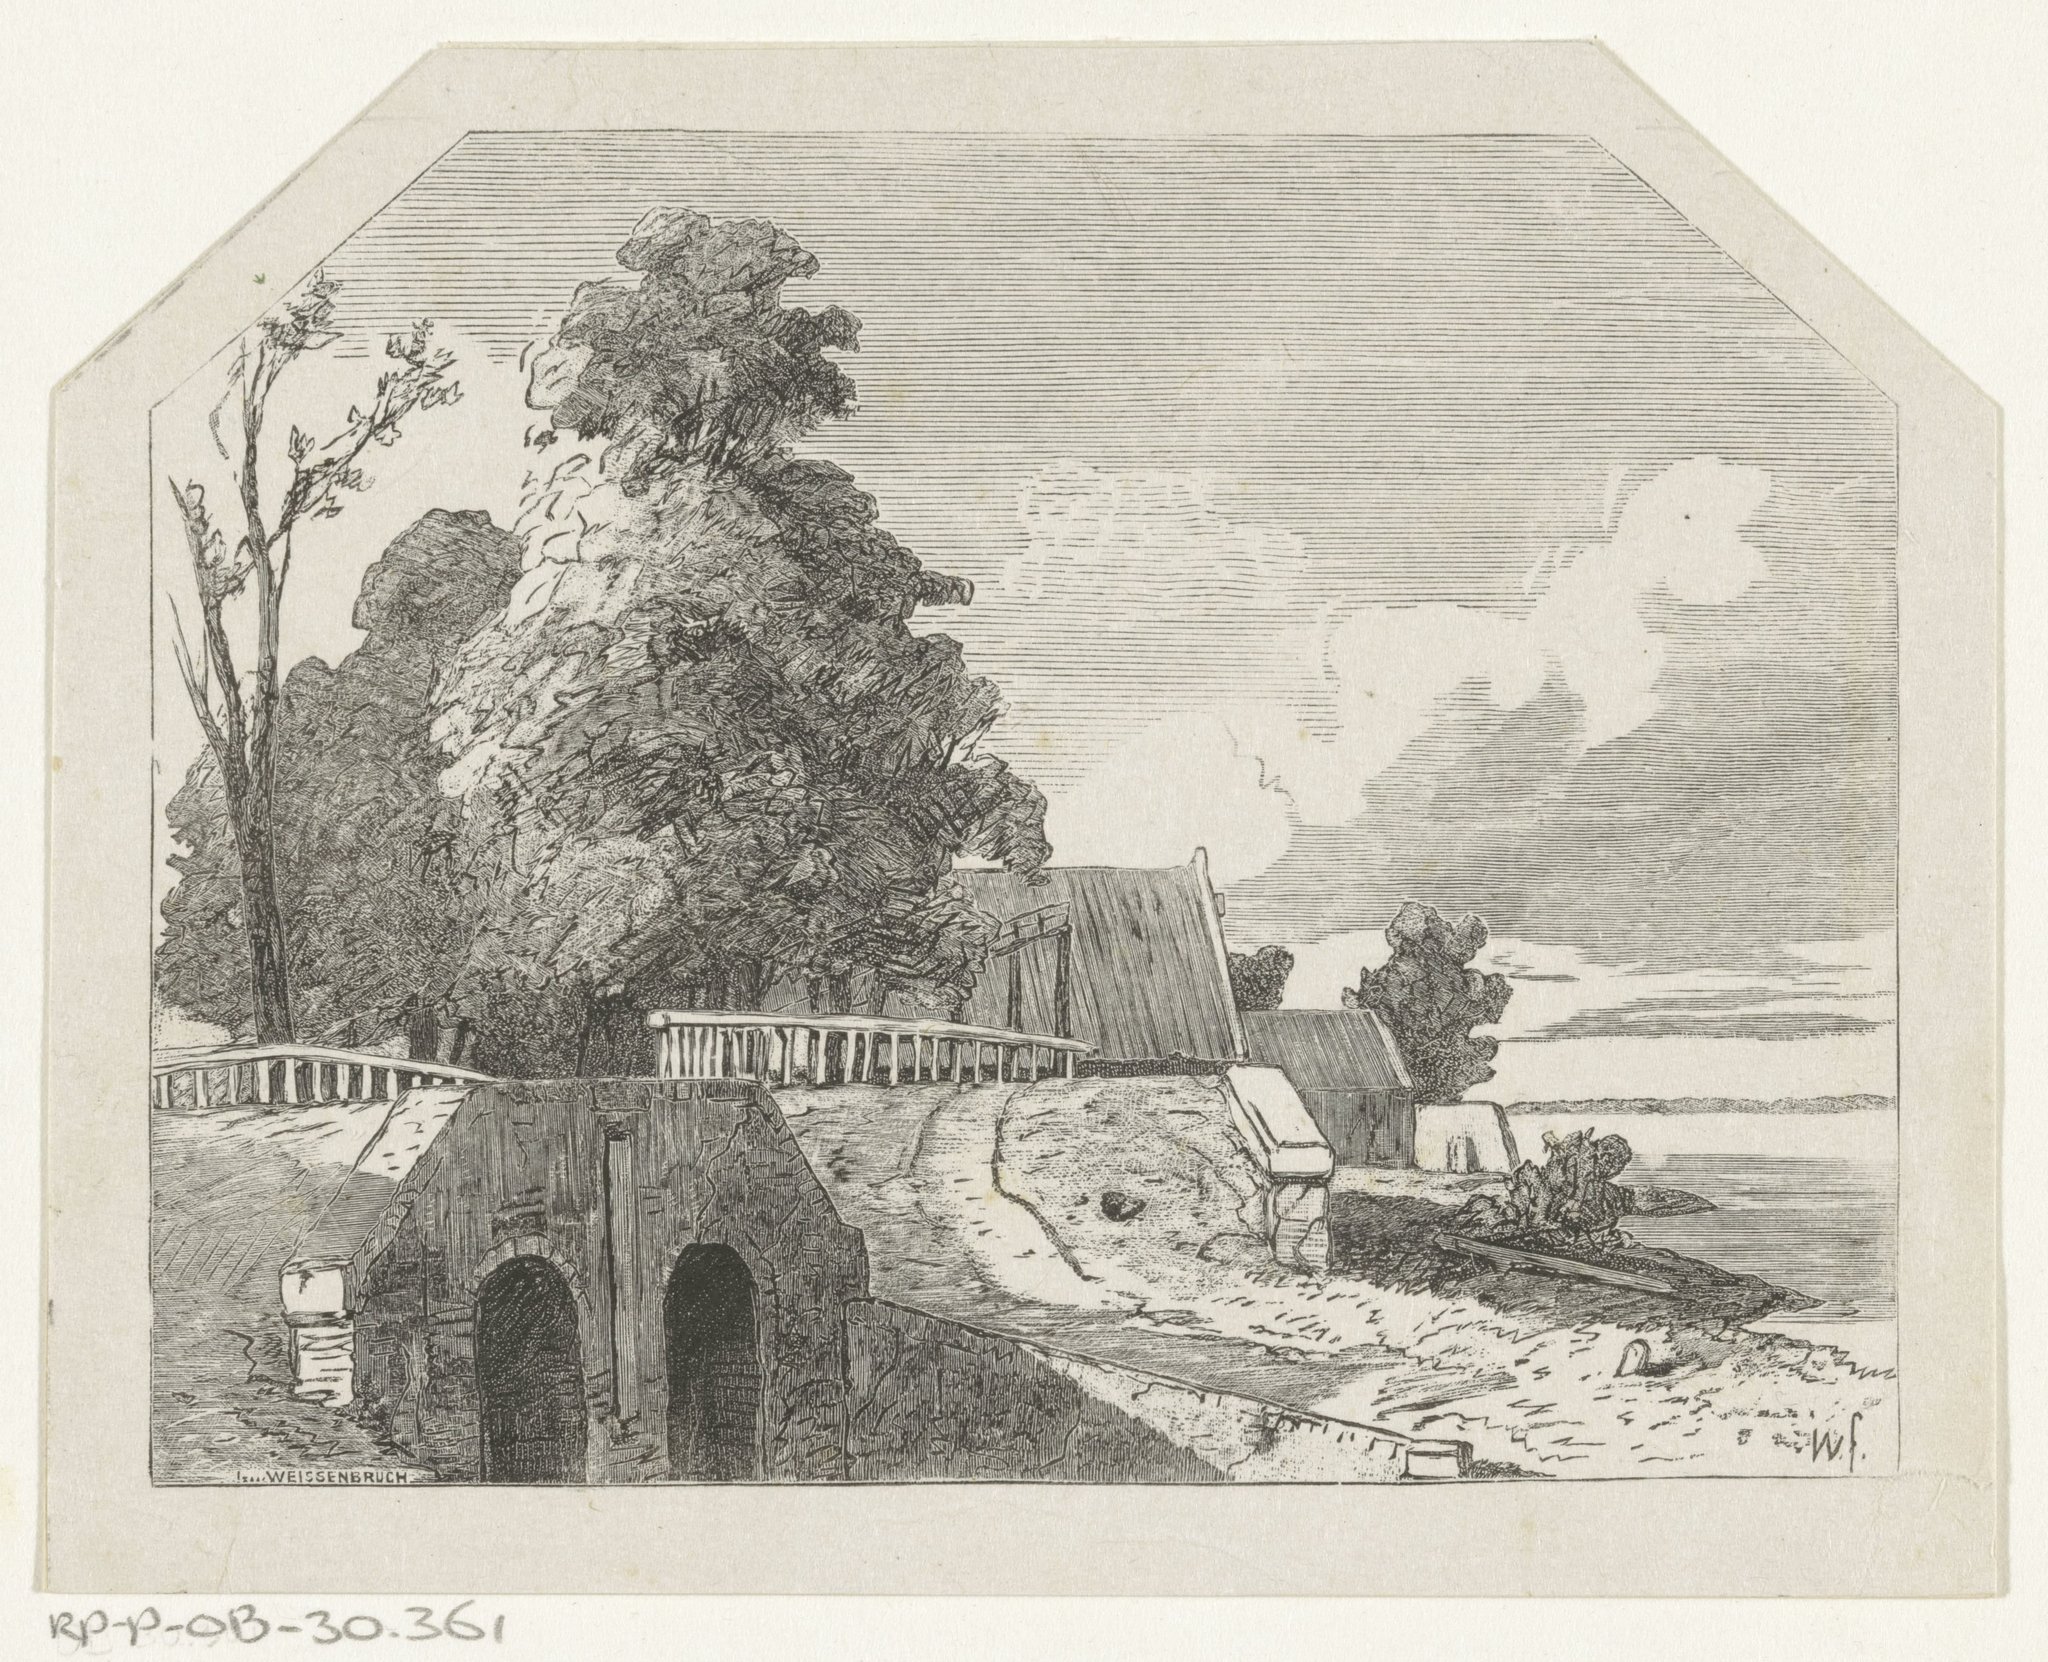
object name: print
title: Landschap met een brug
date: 1836-1912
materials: paper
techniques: engraving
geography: netherlands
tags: landscape with bridge, viaduct or aqueduct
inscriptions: collector's mark: Lugt 2228